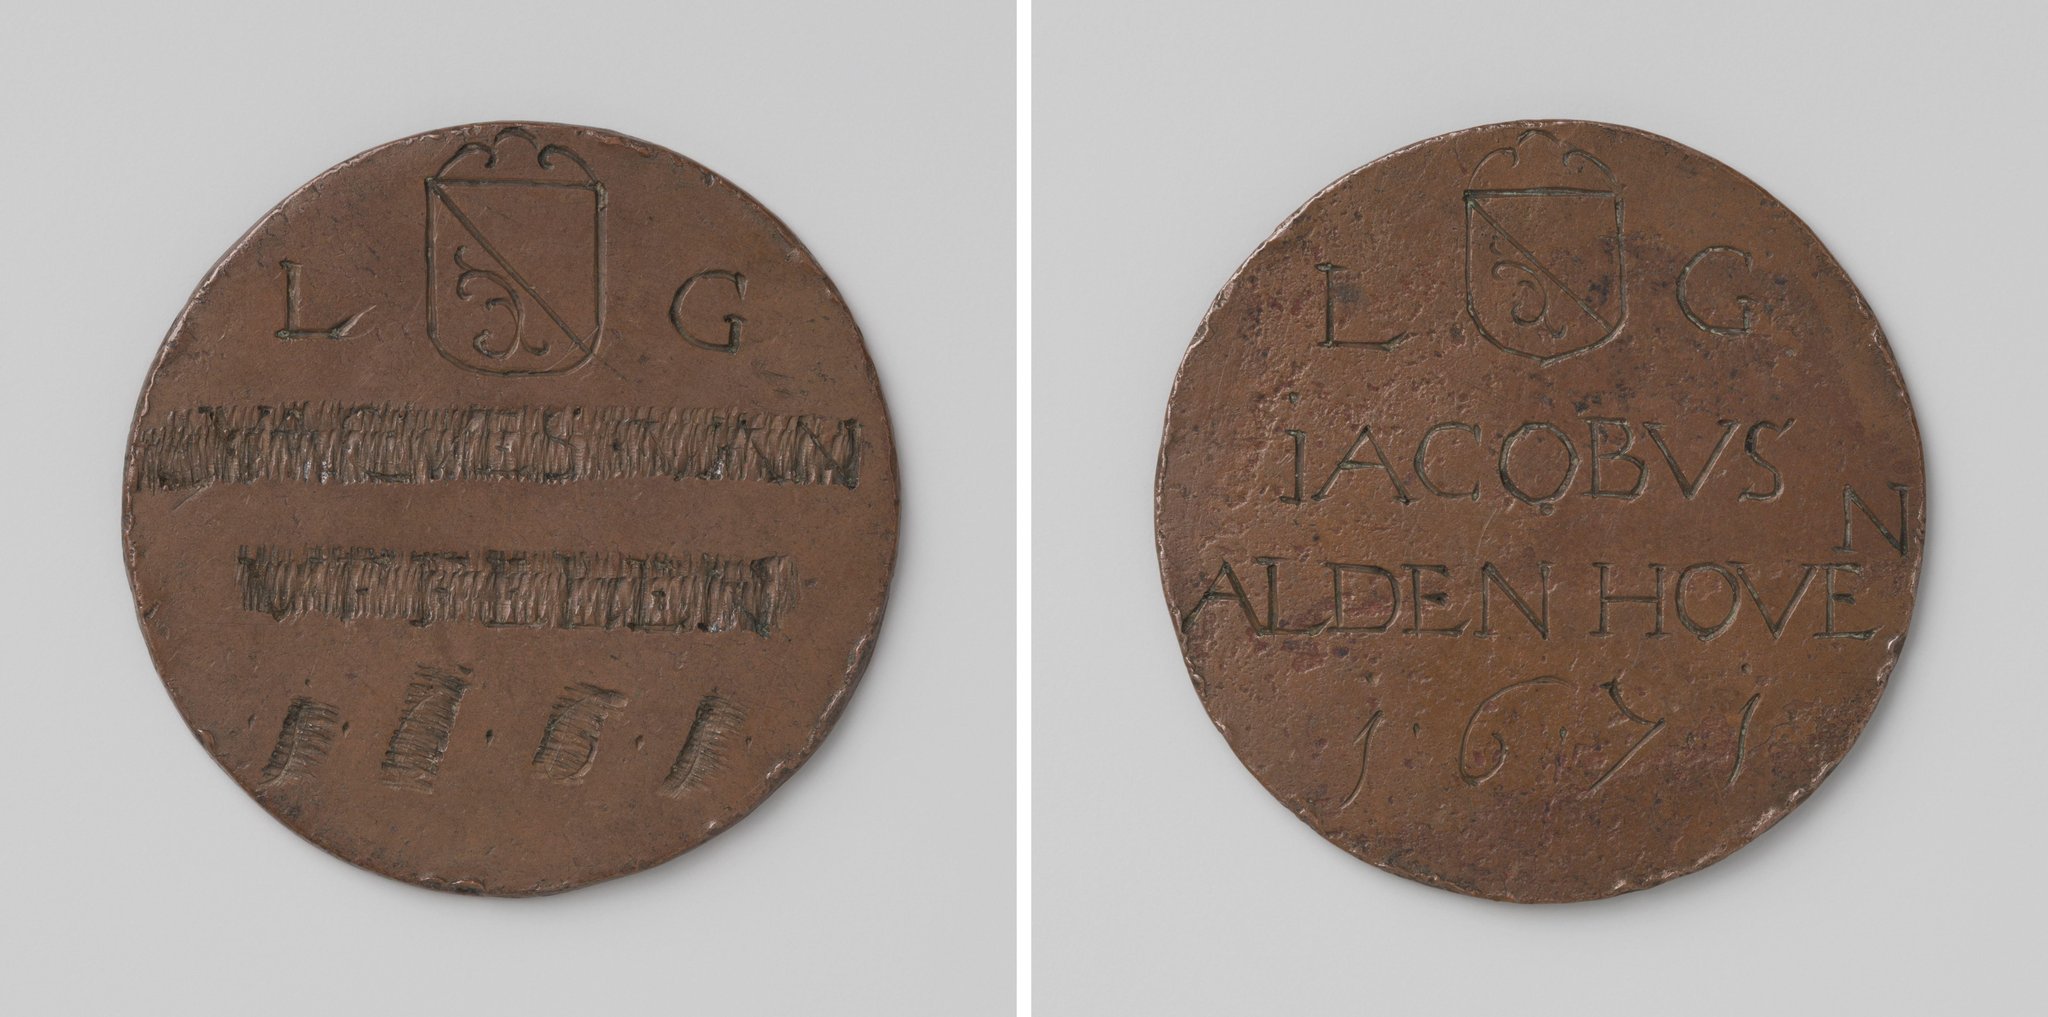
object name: medal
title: Lakenkopersgilde van Utrecht, gildepenning van Jacobus Aldenhove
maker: Anonymous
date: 1671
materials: copper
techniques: engraving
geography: utrecht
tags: utrecht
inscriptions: inscription: ‘L - G / IACOBVS / ALDEN HOVE / 1671’, inscription: ‘L - G / JA(C)QVES VAN / VFFELEN / 16(5 of 6)1’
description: Koperen penning. Voorzijde: wapenschild van Utrecht tussen letters L en G boven de doorgekraste naam Ja(c)ques van Uffelen en jaartal 1651 of 1661. Keerzijde: wapenschild tussen letters L en G boven opschrift.